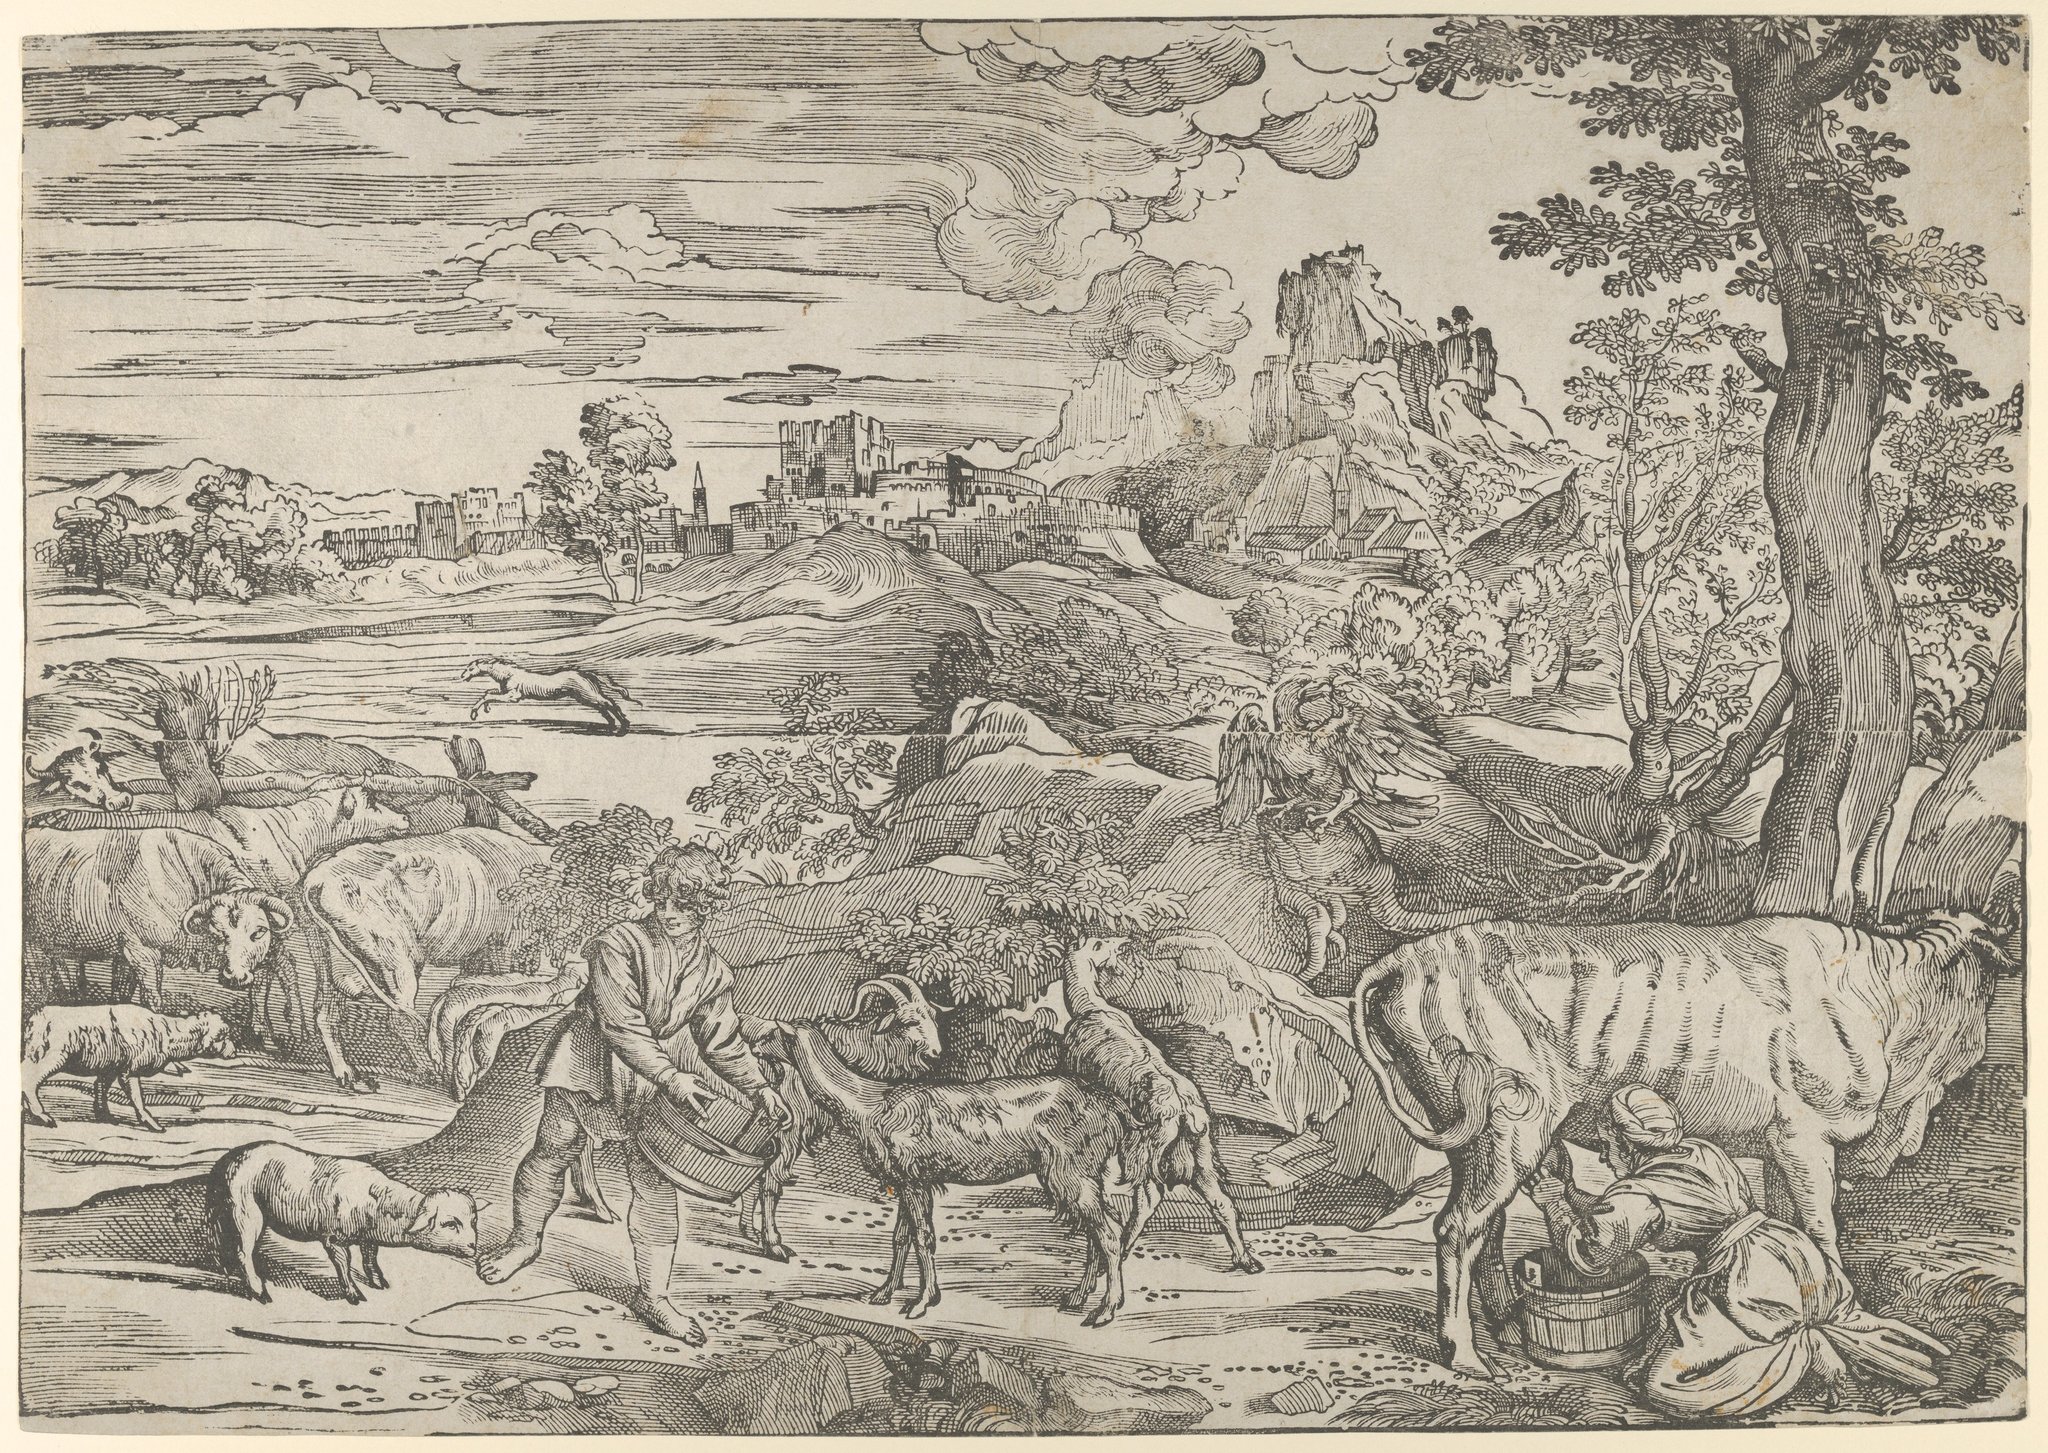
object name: print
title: Landscape with a milkmaid at right and a boy at left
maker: nicolò boldrini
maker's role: artist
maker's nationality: italian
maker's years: 1500-1566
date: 1535-1540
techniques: woodcut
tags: boys,men,cows,goats,landscapes